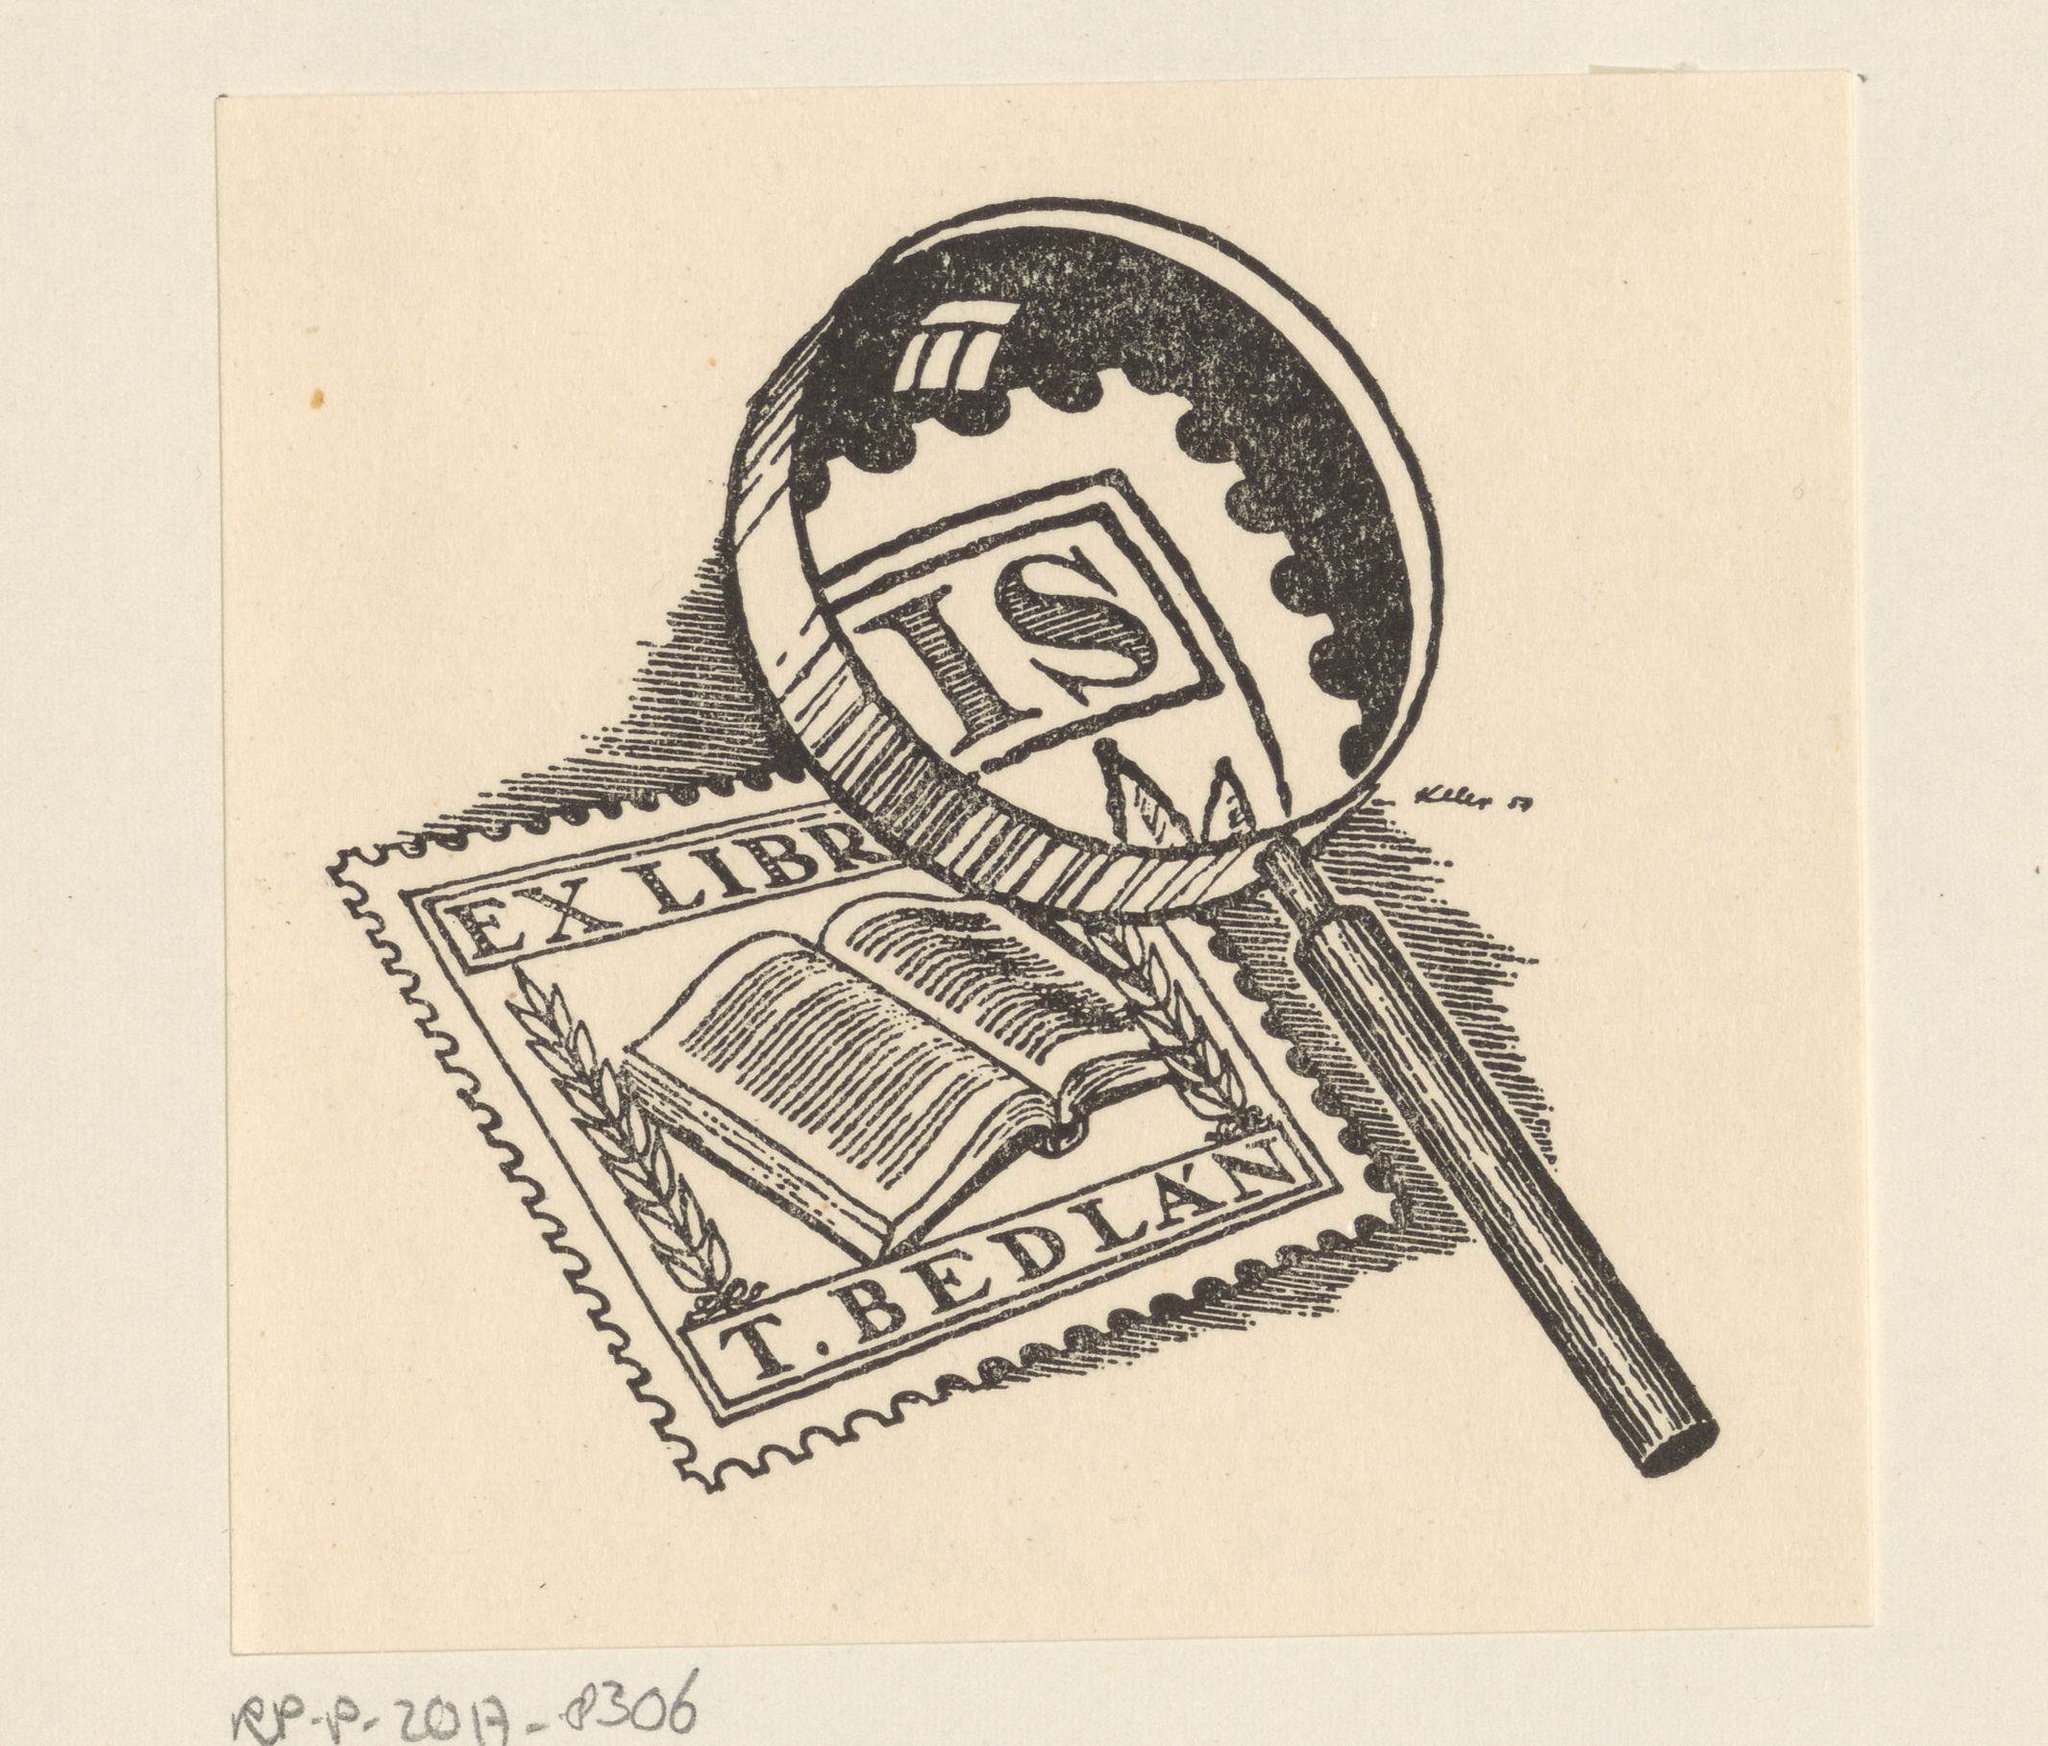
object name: bookplate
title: Ex libris van T. Bedlán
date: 1957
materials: paper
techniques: printing block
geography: czech republic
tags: stamp (~ postal matter), magnifying glass, book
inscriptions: workshop stamp: ‘kresba Štetcem J. Keler - 1957’